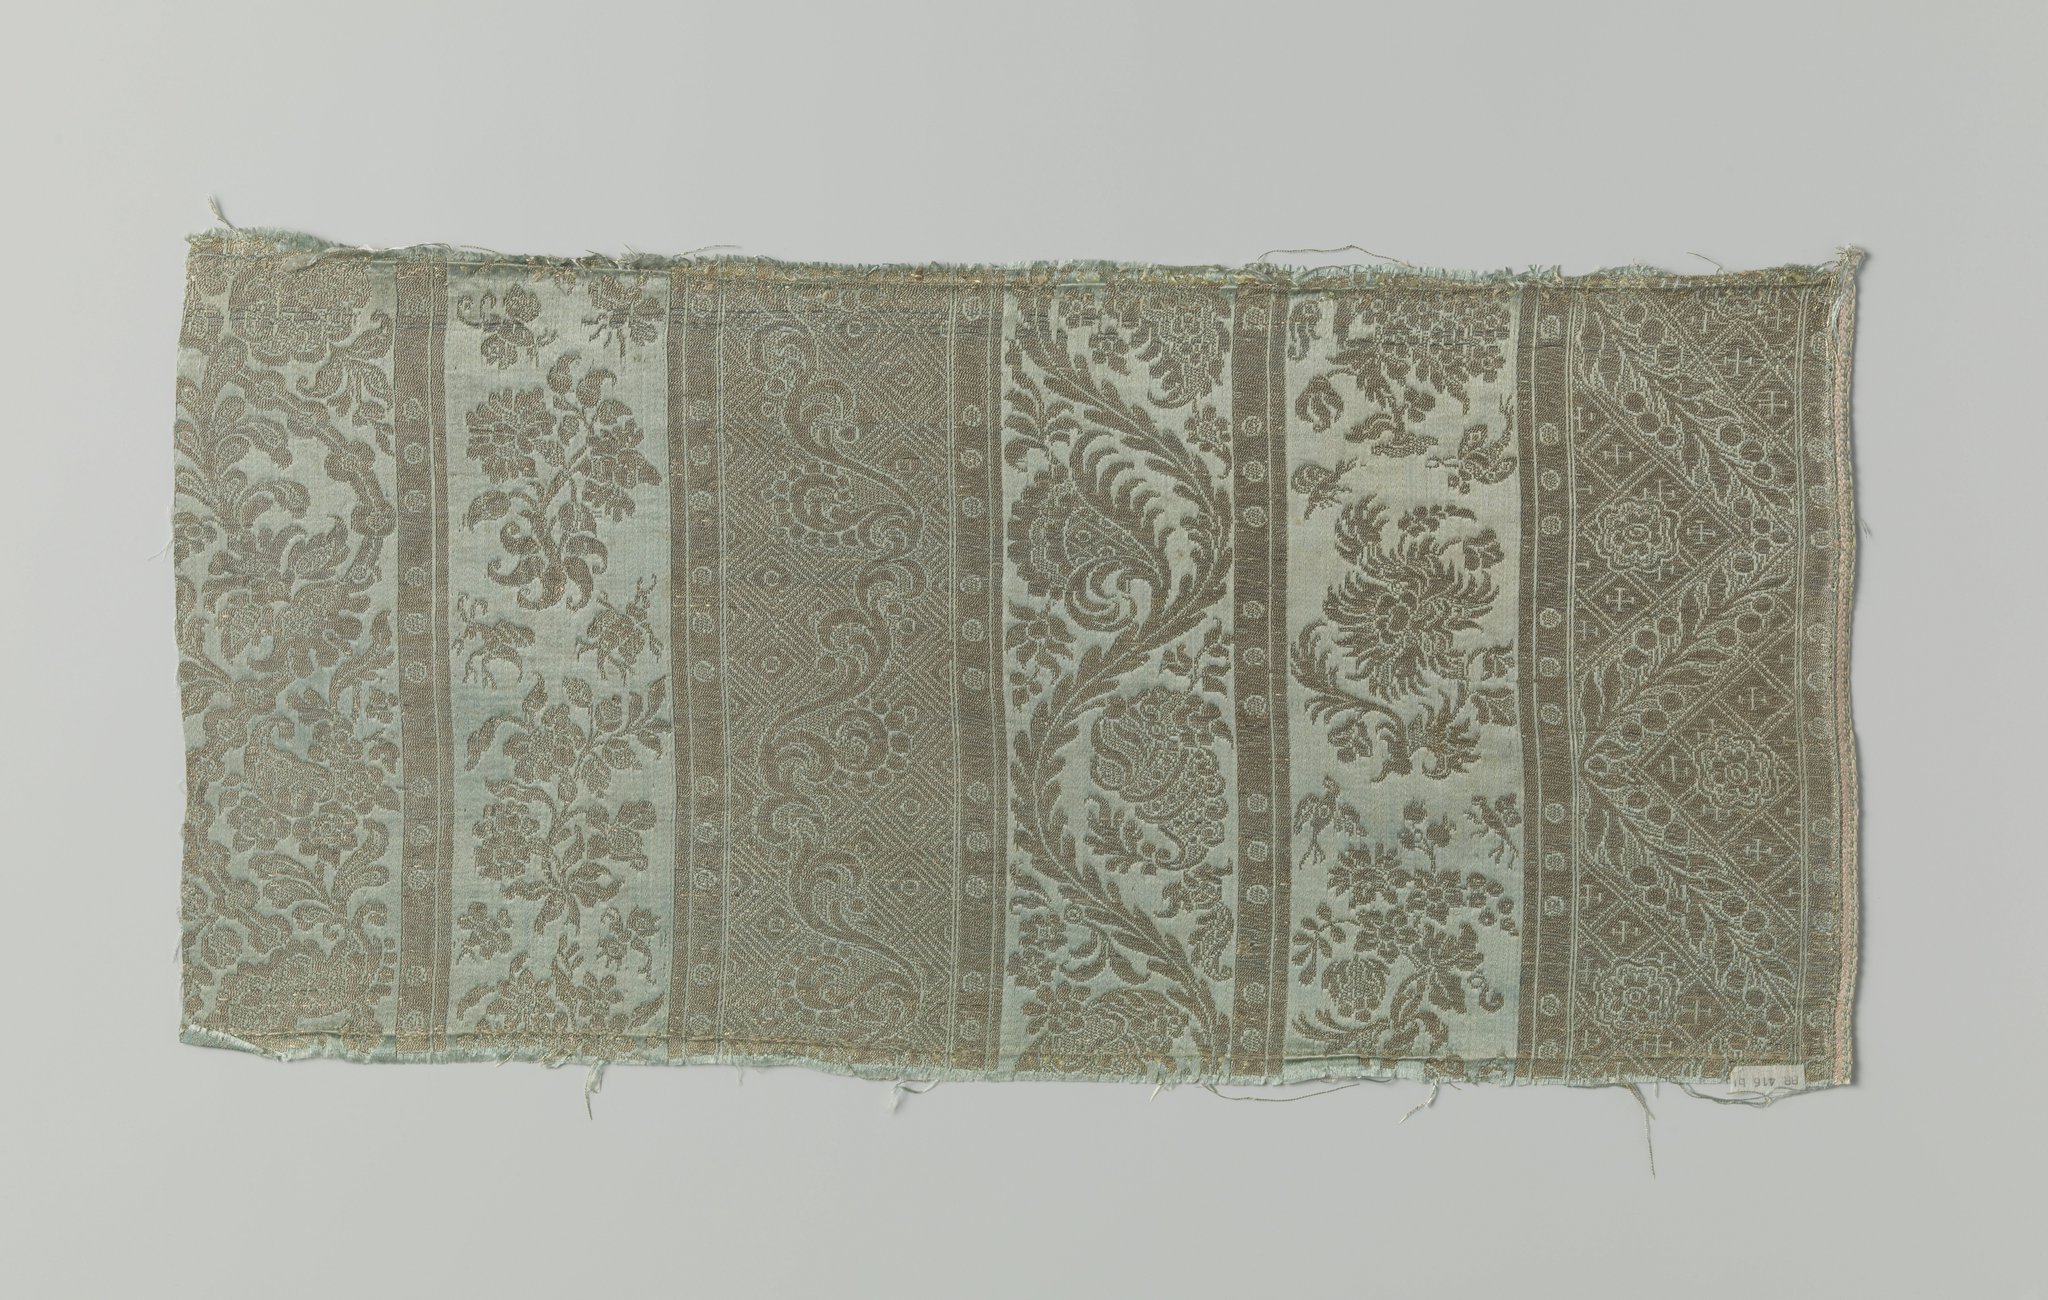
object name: satijnbrokaat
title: Fragment zijden satijnbrokaat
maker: Anonymous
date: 1750-1800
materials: silk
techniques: launching, liseré, satin binding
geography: france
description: Fragment van satijnbrokaat. Het patroon is van goud op blauwe zijde (groen verschoten) en heeft een patroon van afwisselend een baan waarbinnen geometrische vormen, een baan waarbinnen bloemboeketten en een baan waarbinnen bloemslingers. Het patroon is identiek aan BK-NM-1232.